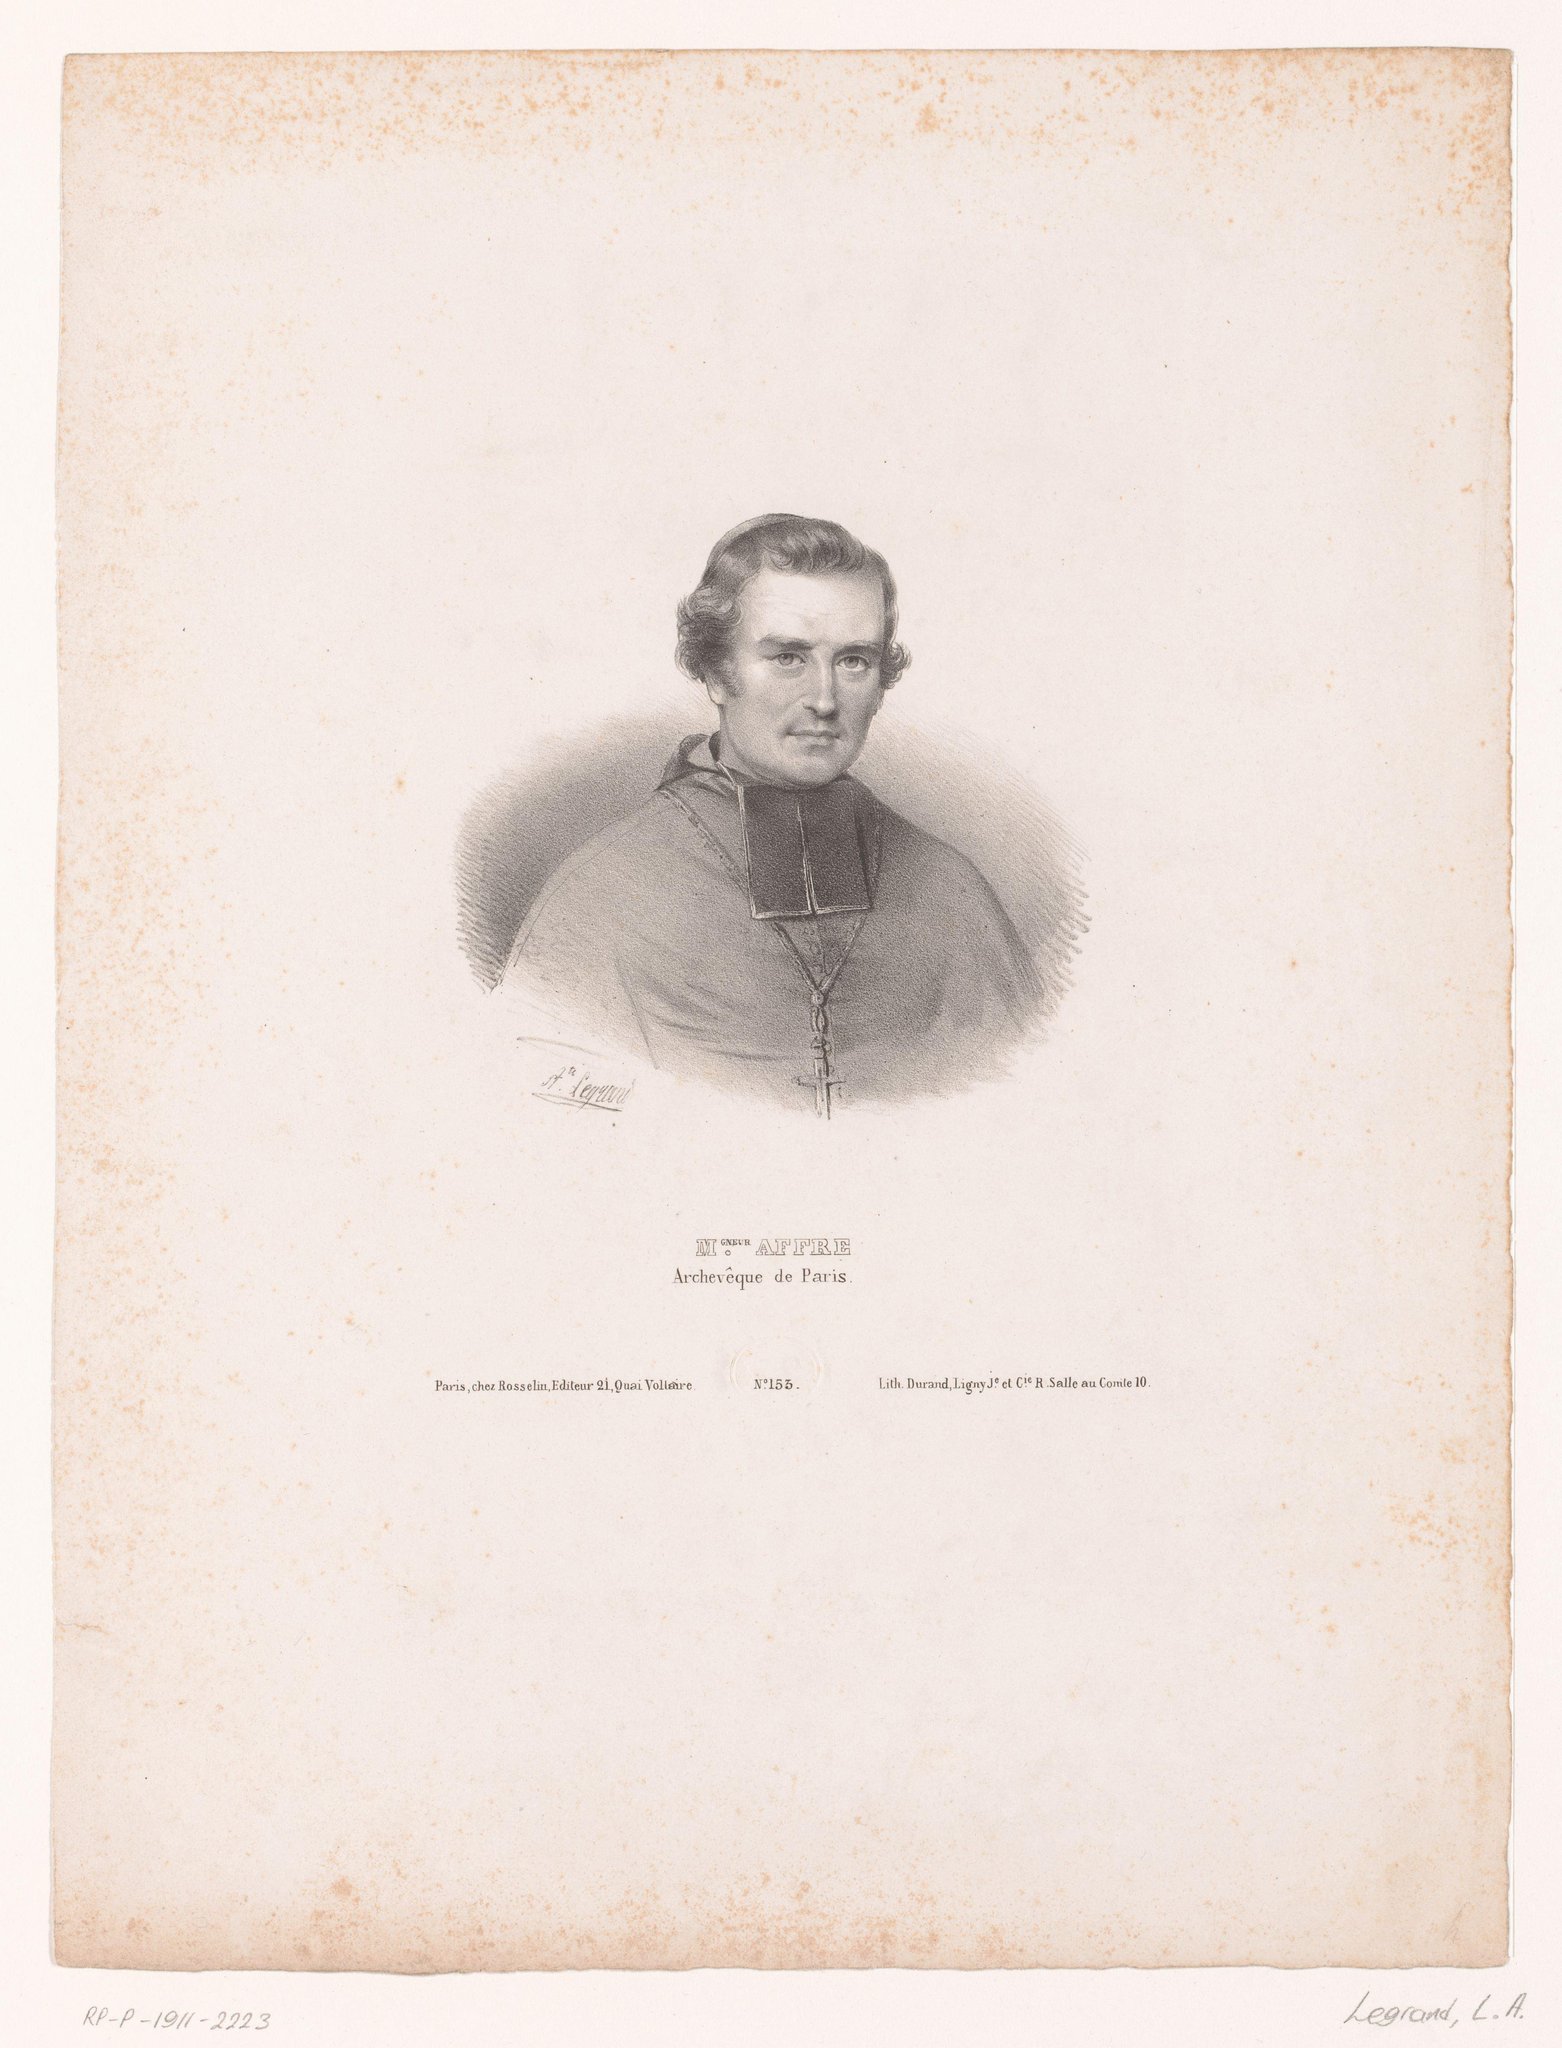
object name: print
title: Portret van Denys Auguste Affre, aartsbisschop van Parijs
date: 1840-1844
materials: paper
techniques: lithograph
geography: paris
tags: paris, historical persons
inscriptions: check stamp: Lugt 3693, collector's mark: Lugt 2228a